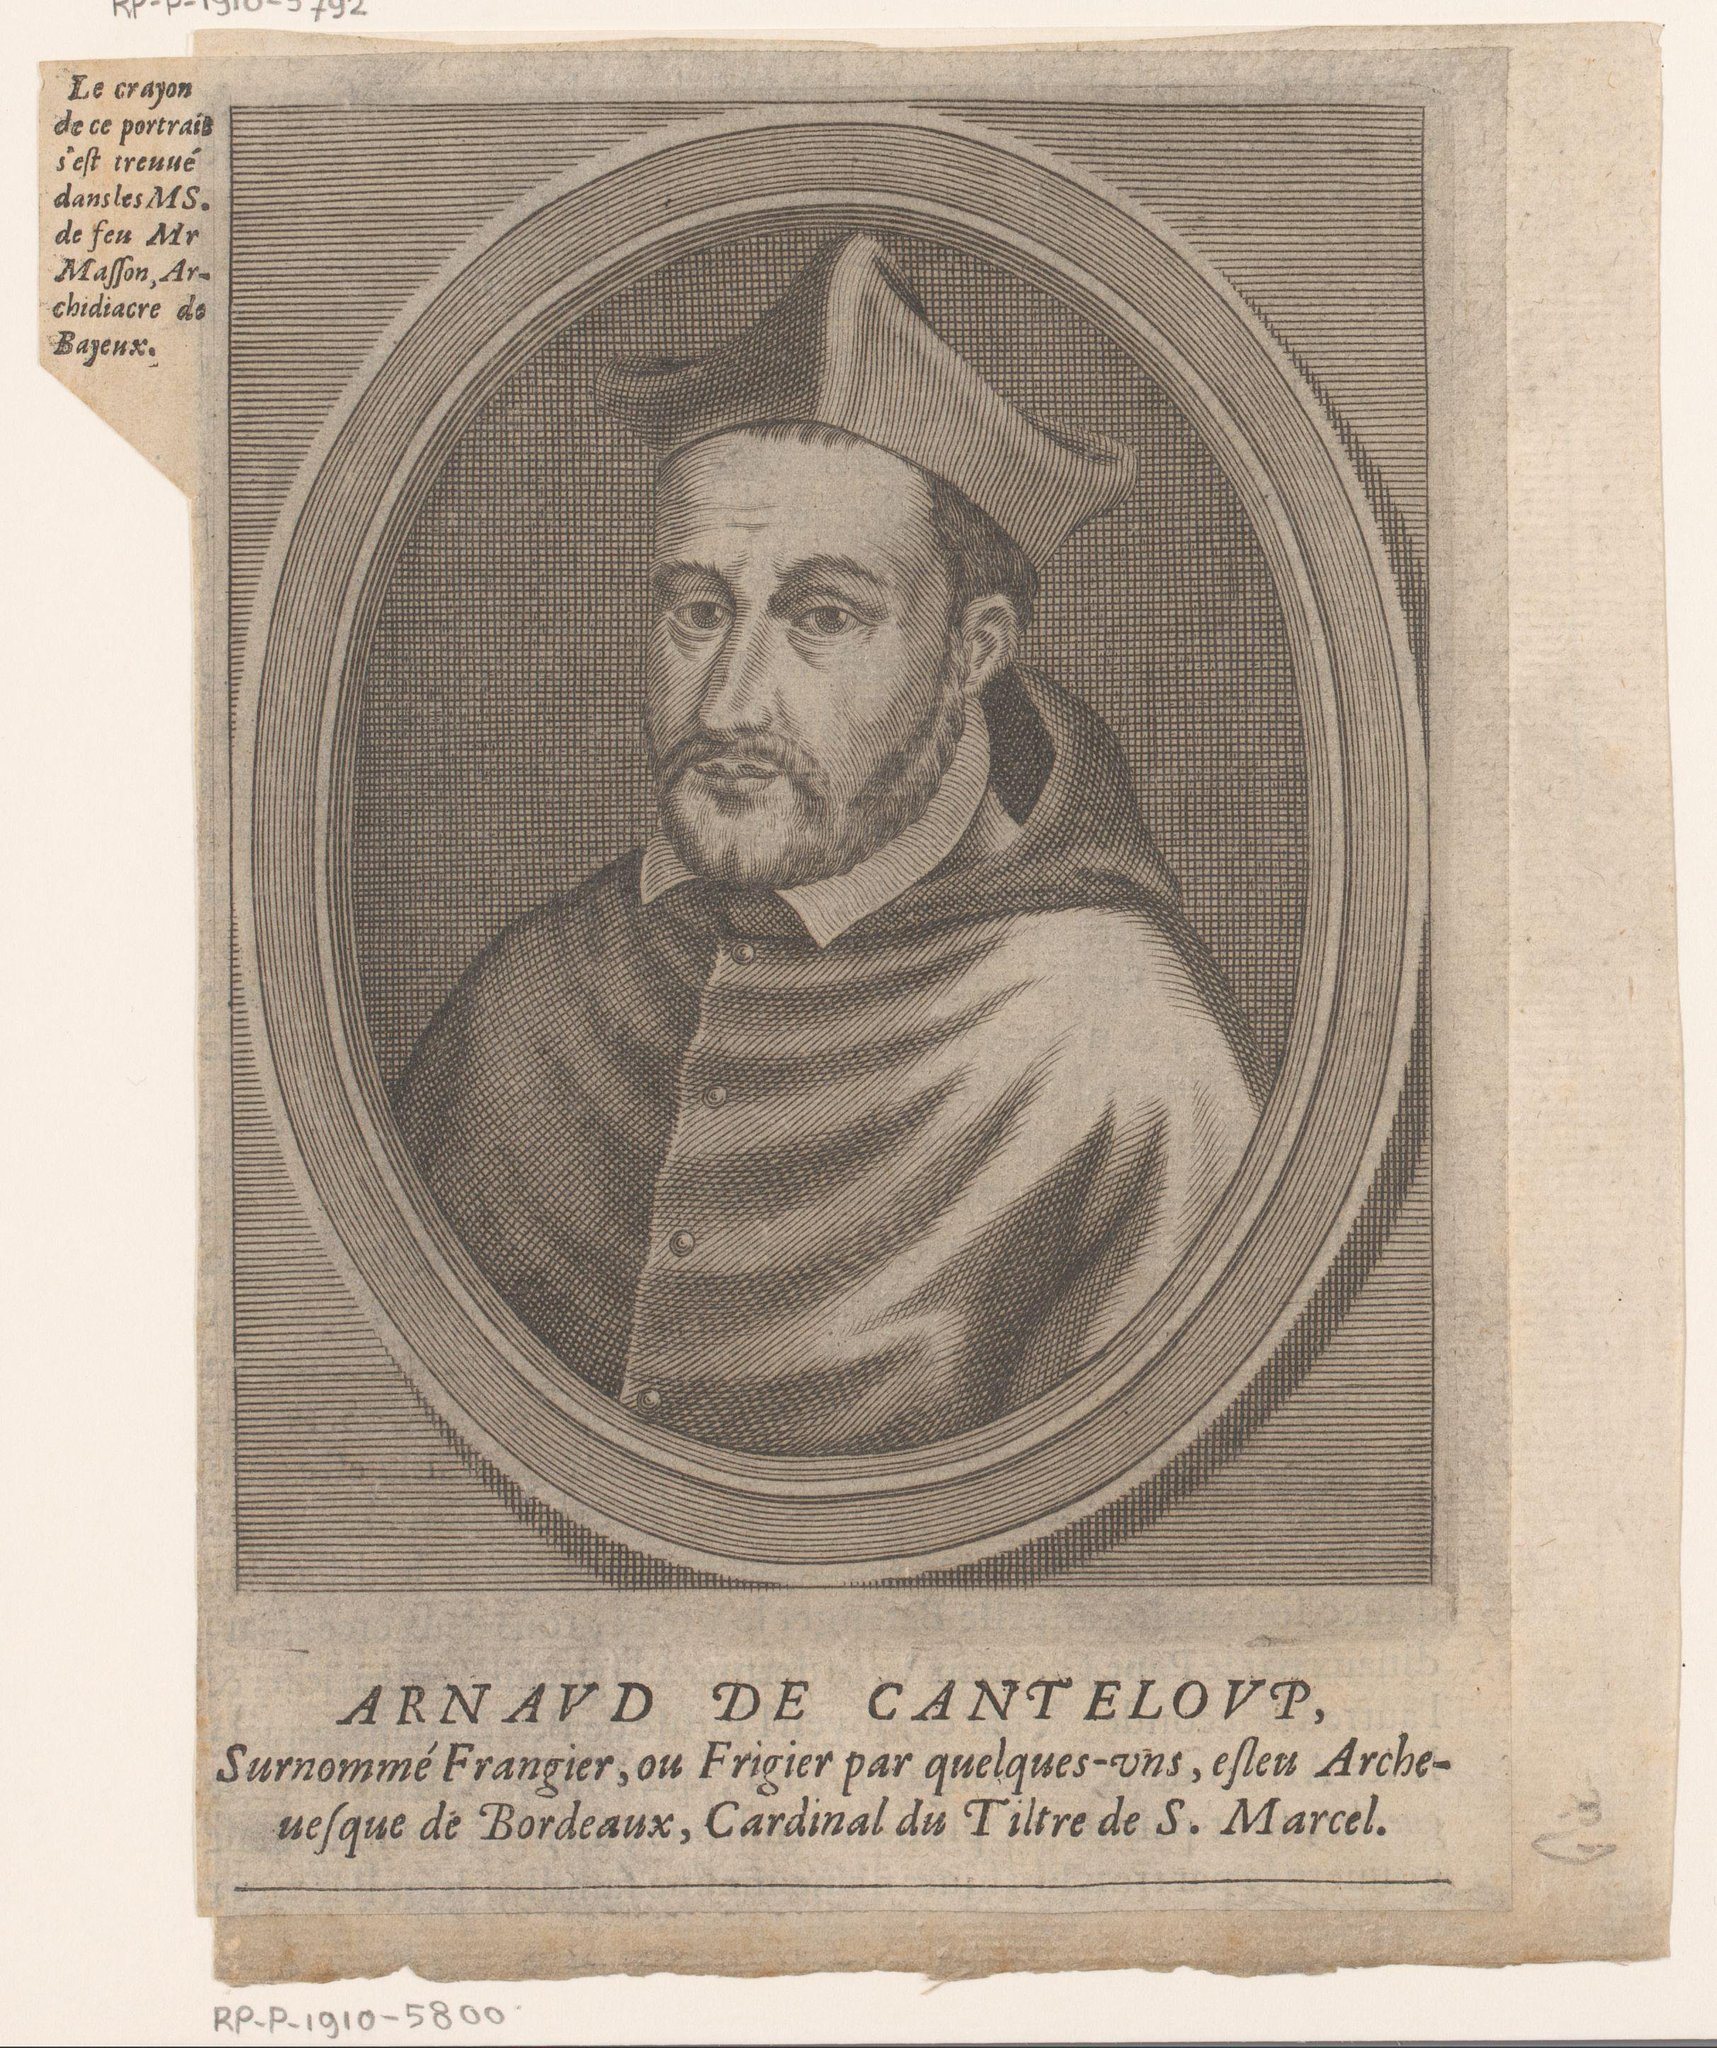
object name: print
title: Arnaud de Canteloup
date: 1660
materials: paper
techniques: engraving, etching, letterpress printing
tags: archbishop, bishop, etc. (roman catholic), historical persons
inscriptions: collector's mark: Lugt 2228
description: Prent uit: Du Chesne, François. Histoire de tous les cardinaux françois de naissance, ou qui ont esté promeus au cardinalat. Parijs: François Du Chesne, 1660.